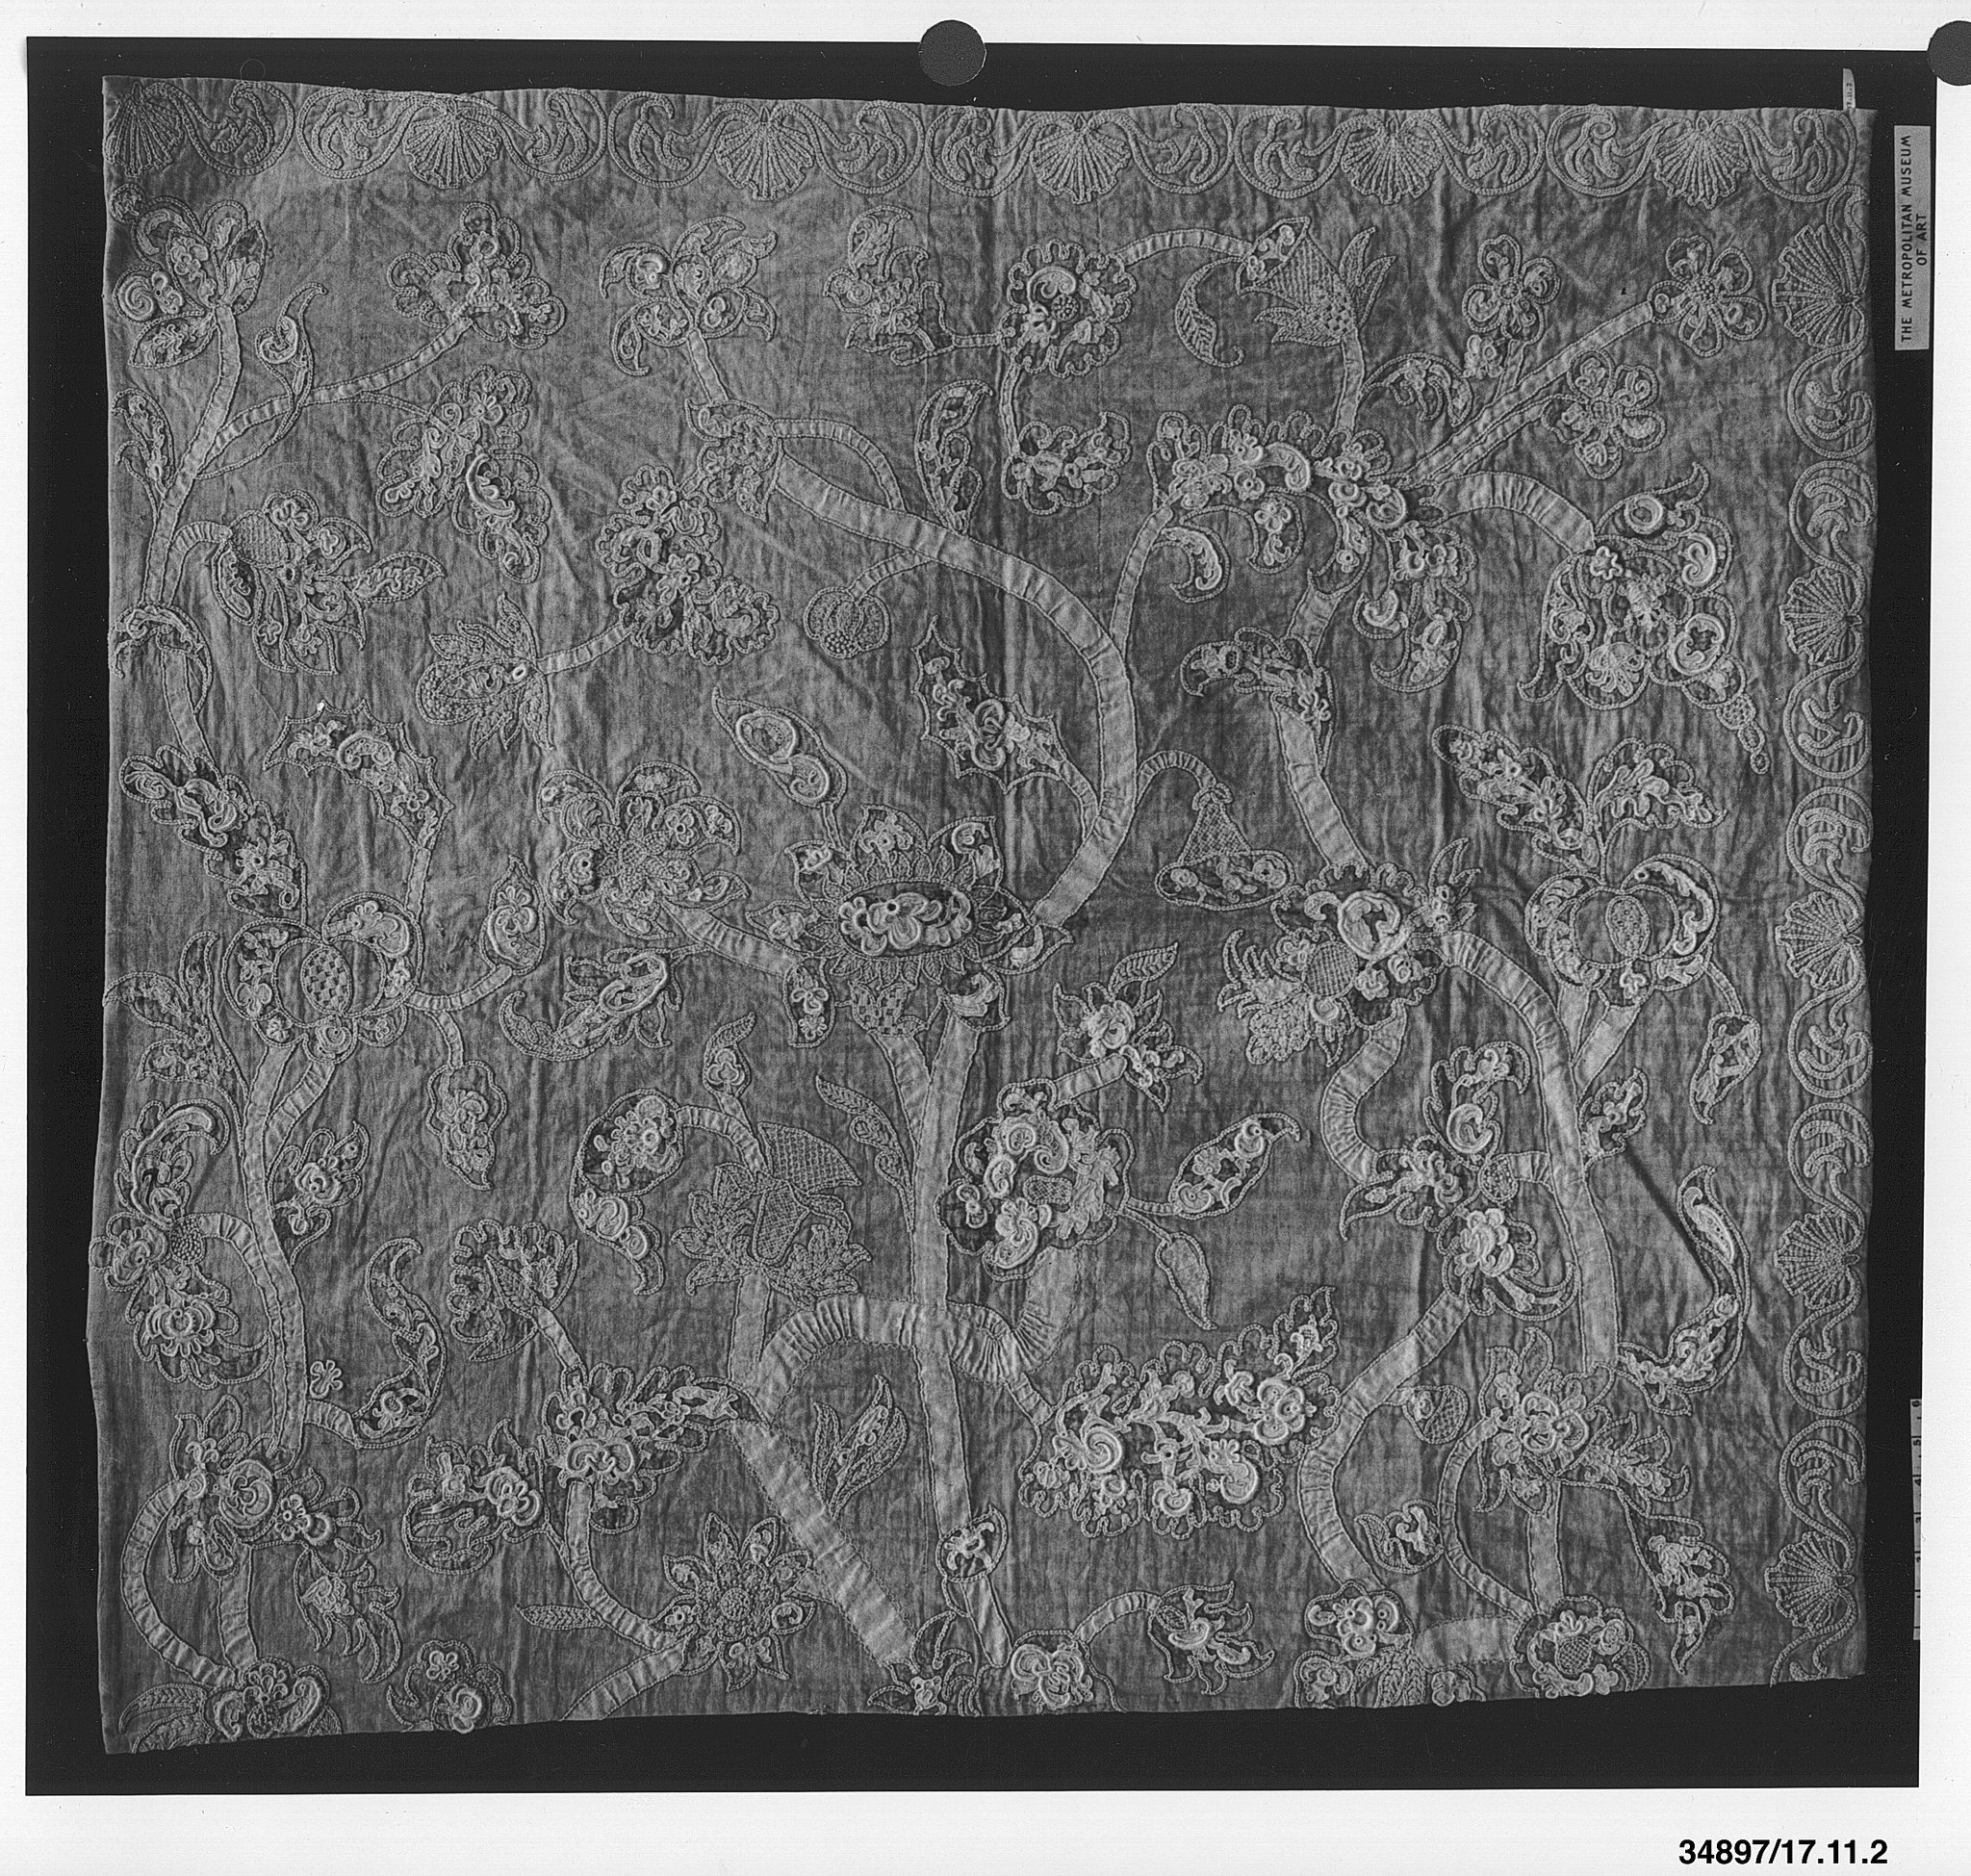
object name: cover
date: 1601-1700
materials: lace, linen